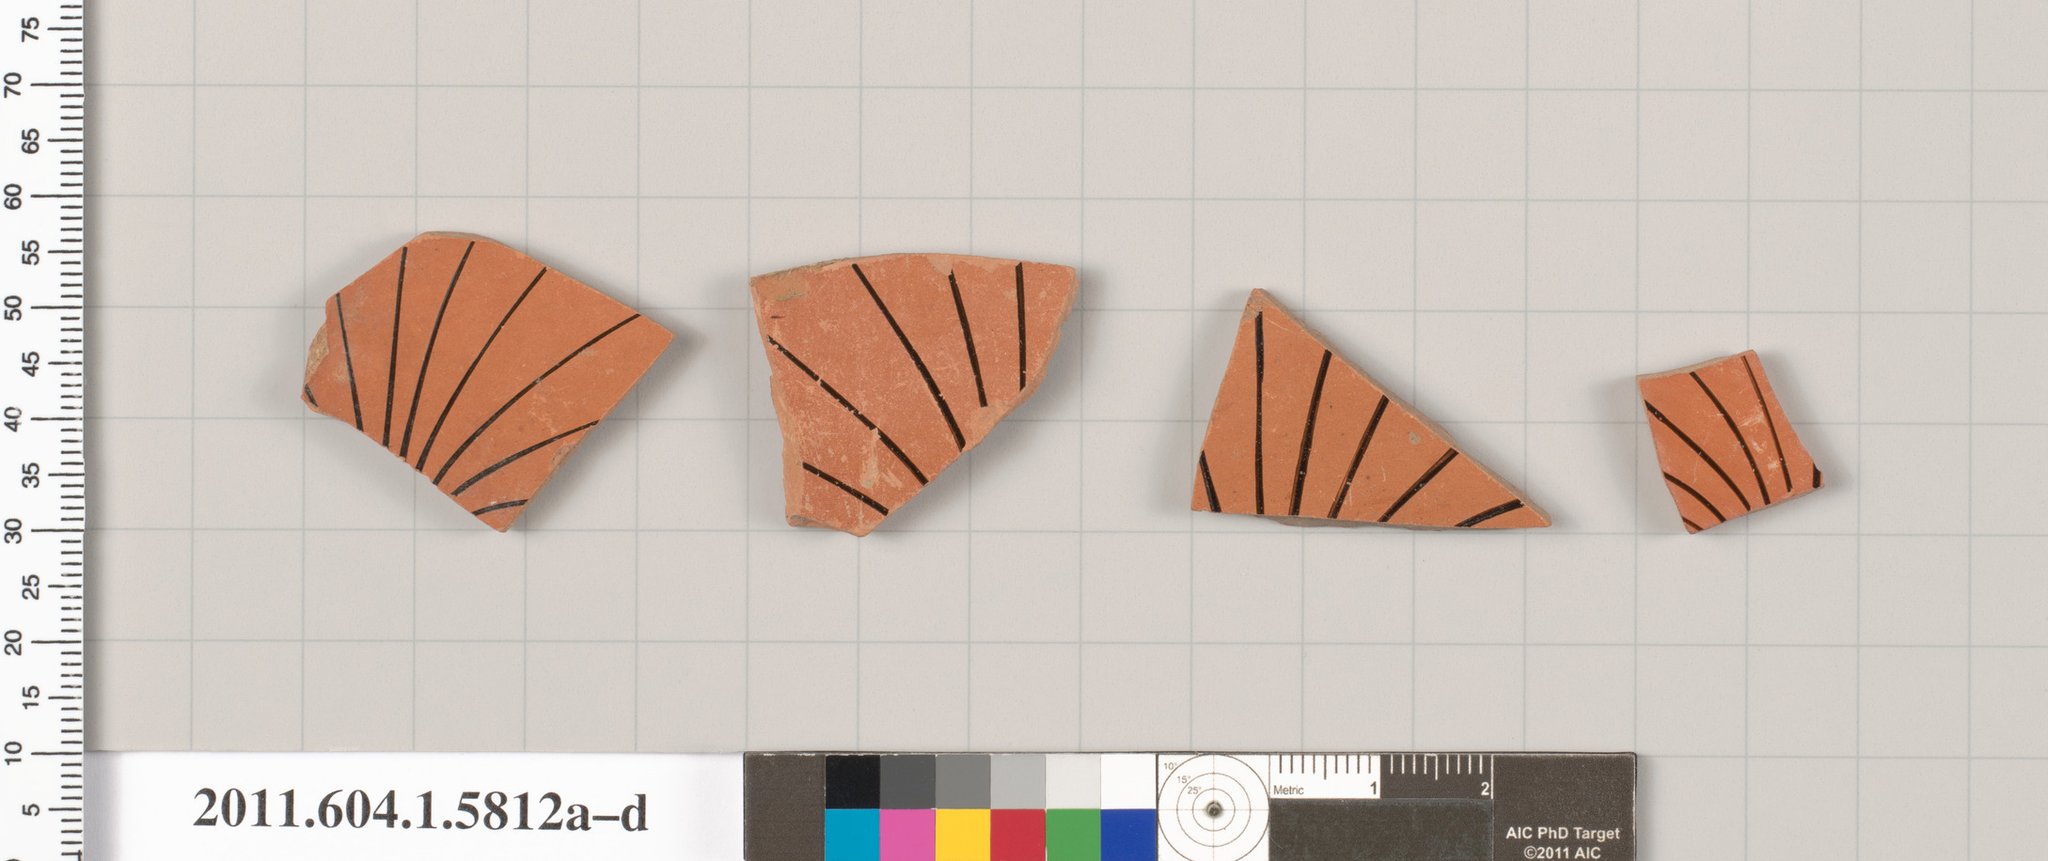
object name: kylix fragment, eye cup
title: Terracotta fragments of kylikes: eye-cups (drinking cups)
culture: greek, attic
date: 520-510 BCE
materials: terracotta